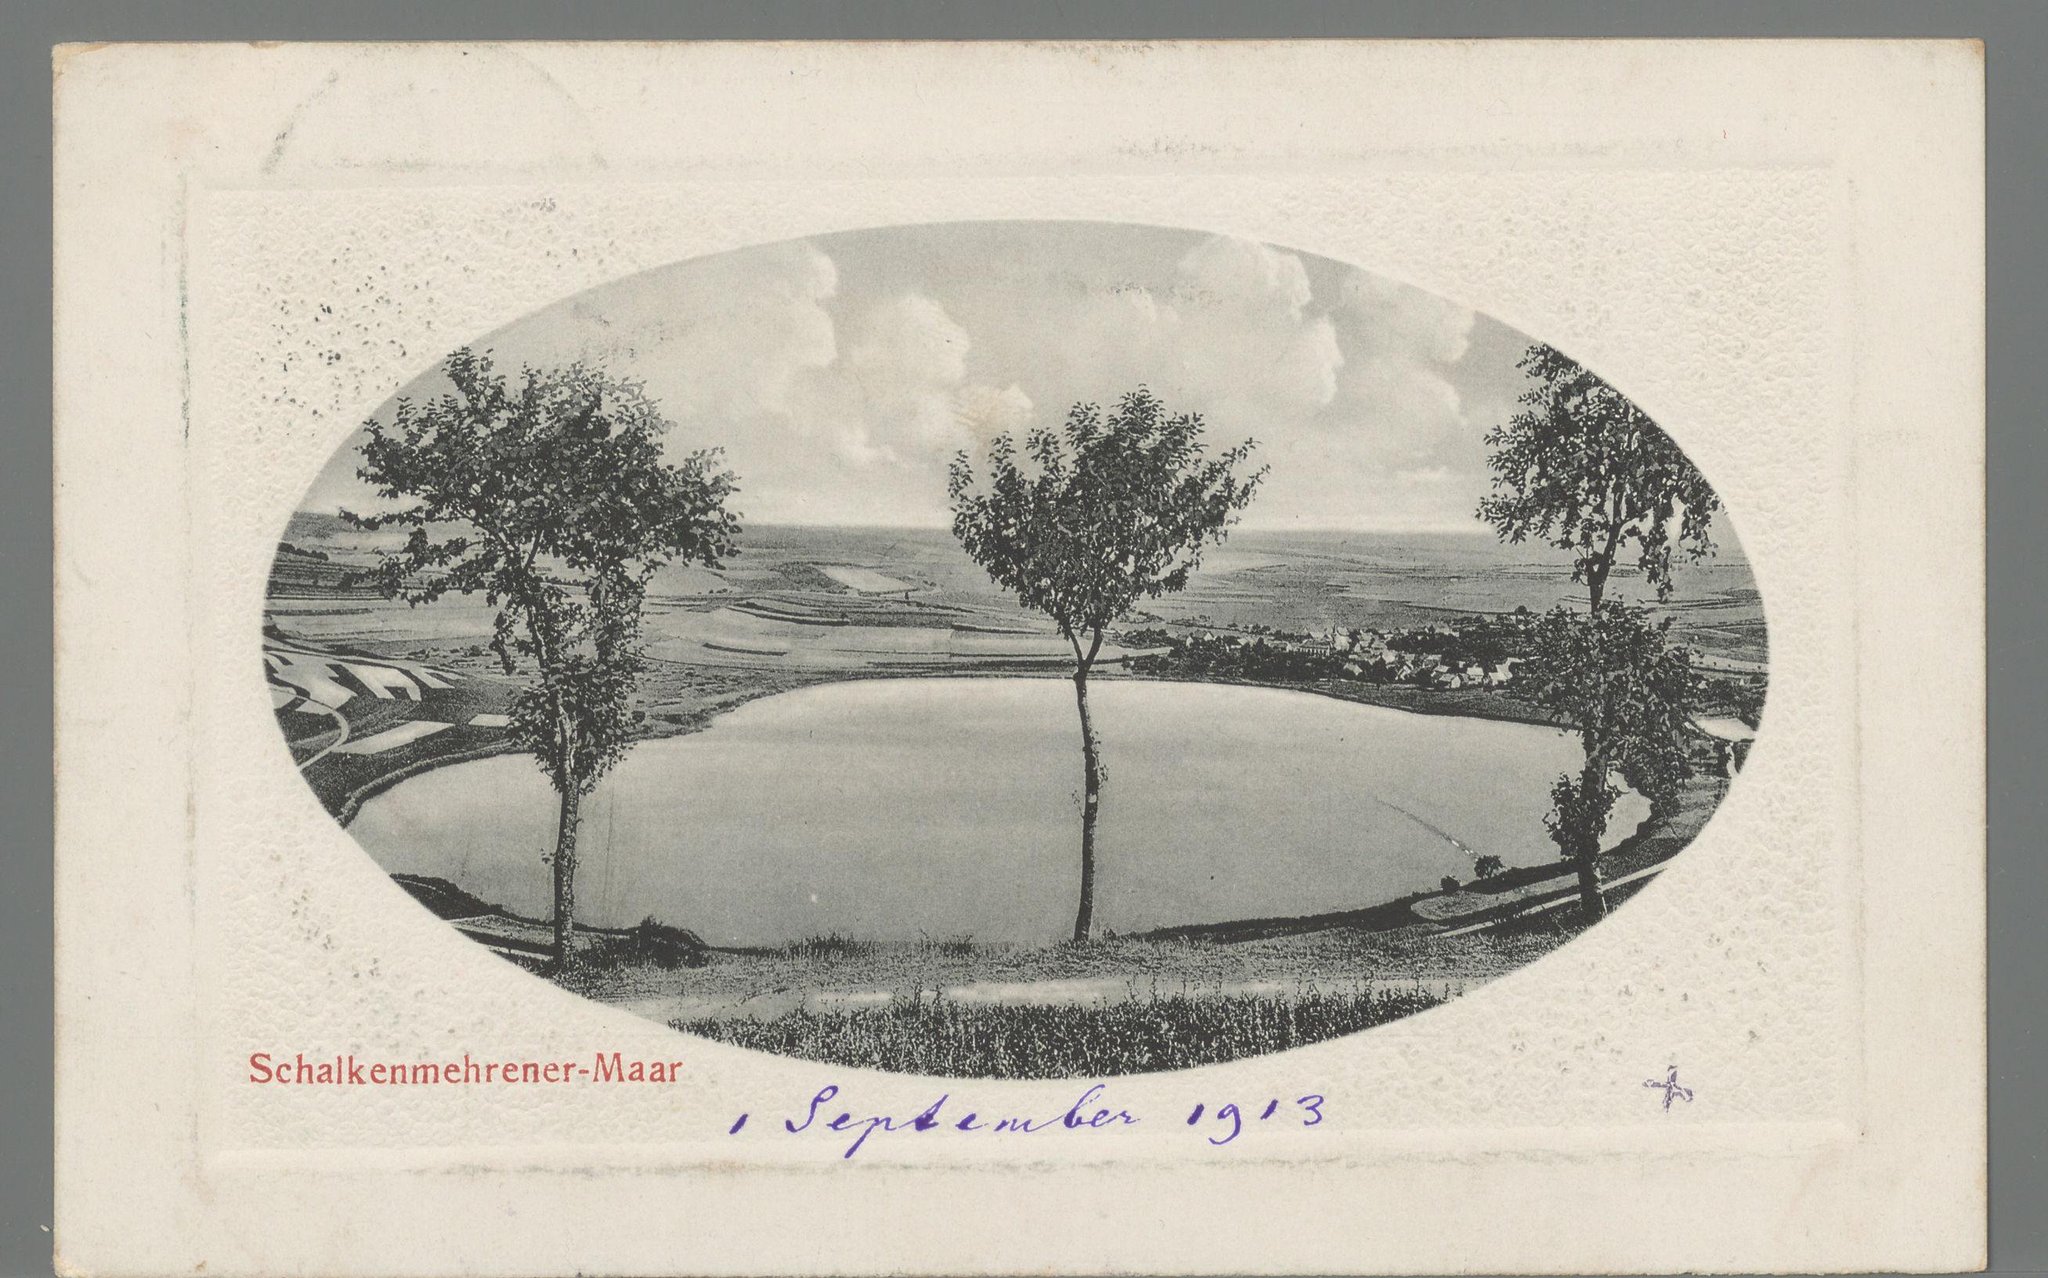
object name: ansichtkaart, prentbriefkaart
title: Schalkenmehrener-Maar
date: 1905-1913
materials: cardboard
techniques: photograph, writing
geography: daun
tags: lake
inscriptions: postage stamp